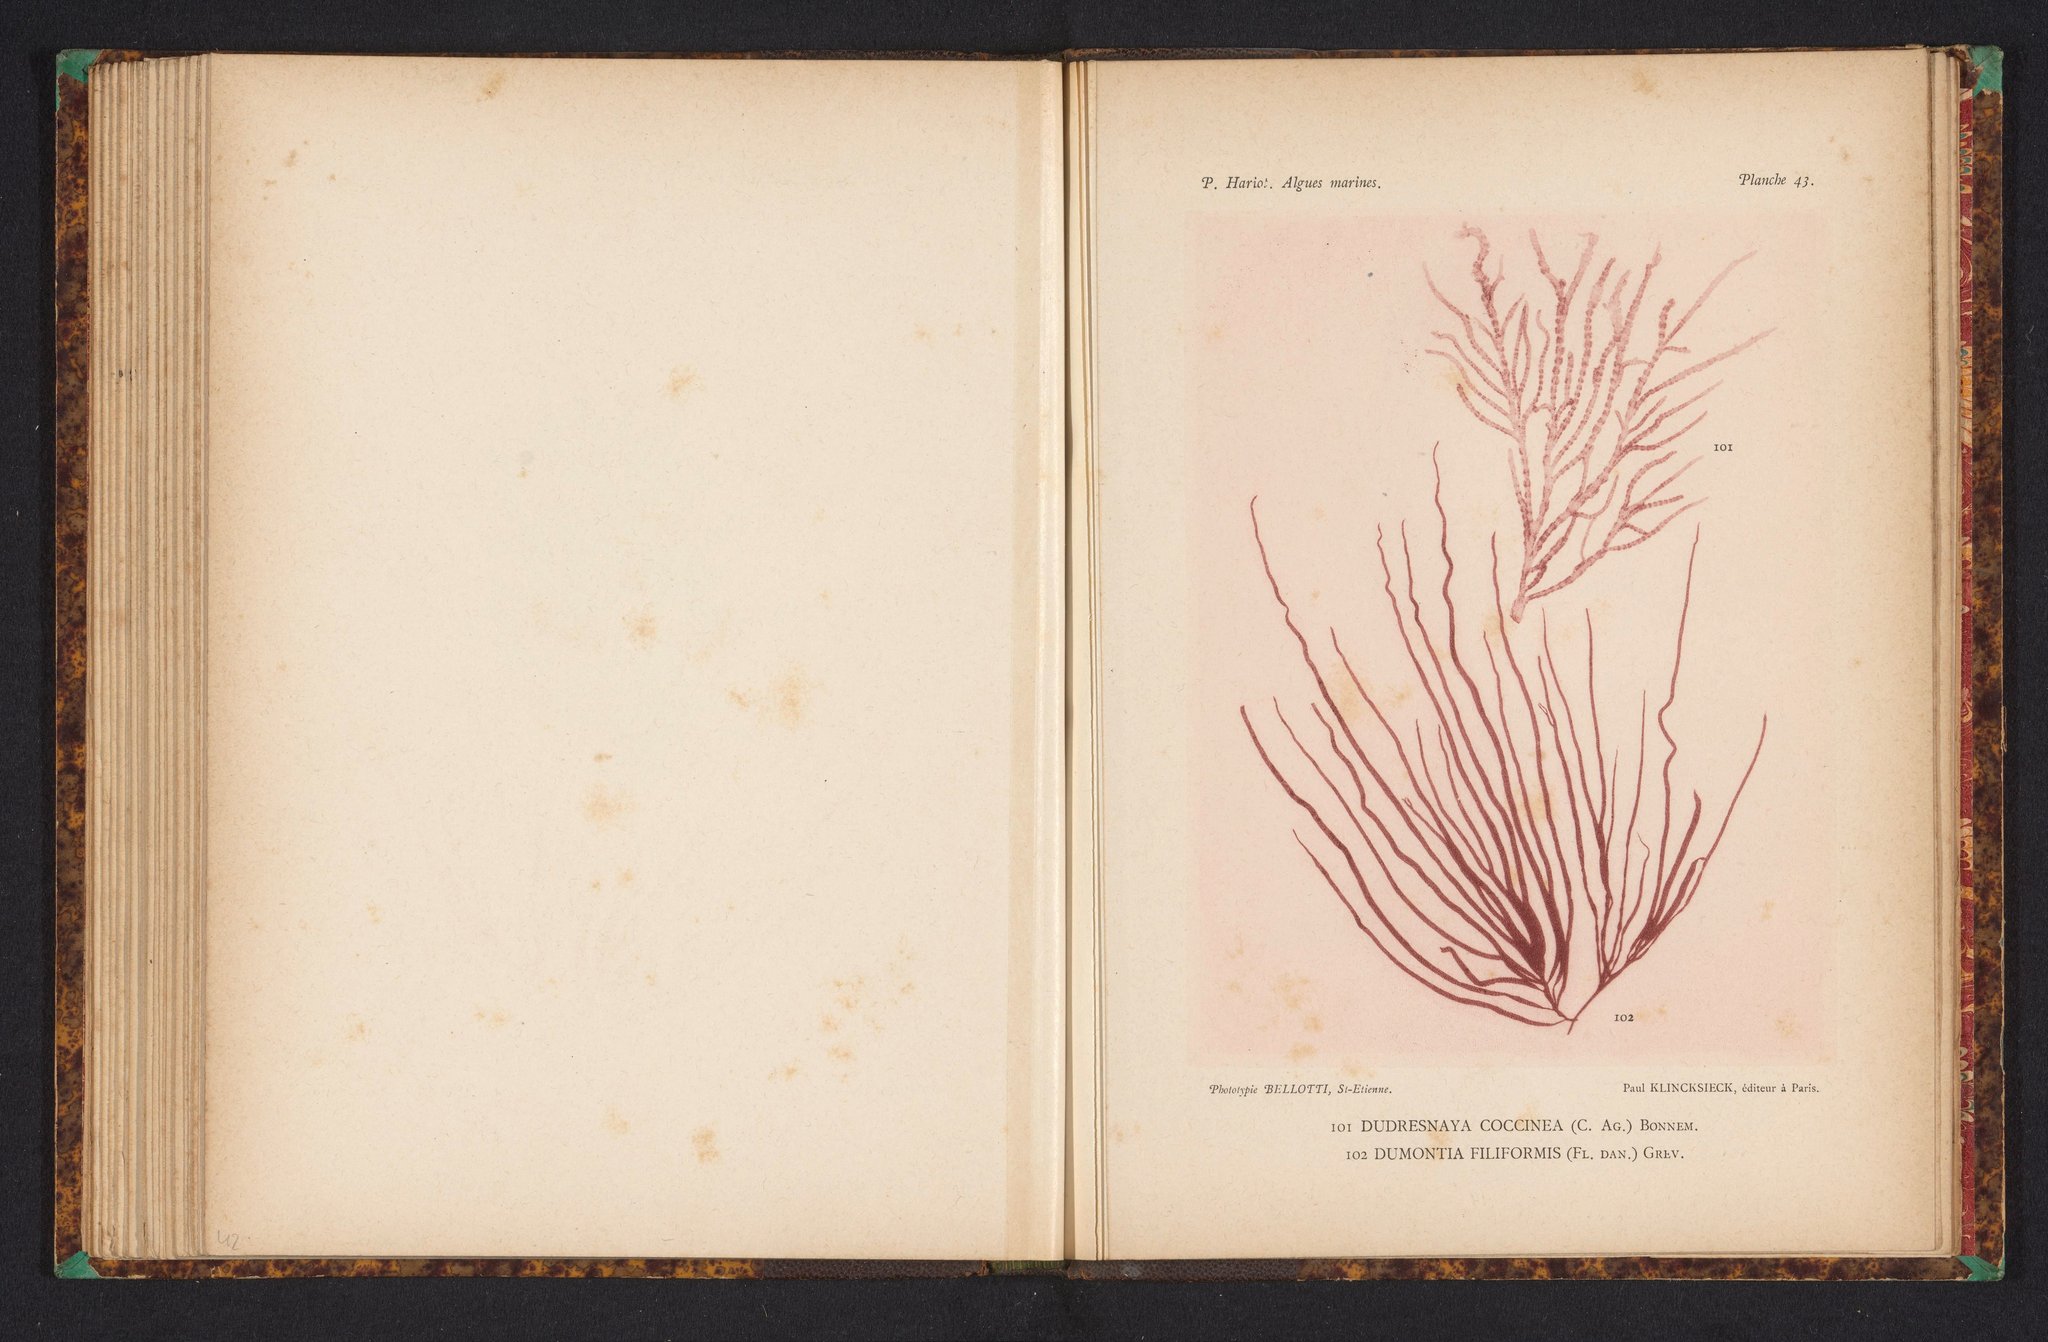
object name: photomechanical print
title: Twee soorten zeewier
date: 1882-1892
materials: paper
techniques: photograph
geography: france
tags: algae, seaweed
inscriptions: number: ‘101 (...) 102’, inscription: ‘Dudresnaya (...) filiformis (Ft. Dan.) Grev.’, number: ‘Planche 43.’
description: (101) is Dudresnaya coccinea, (100) is Dumontia filiformis.